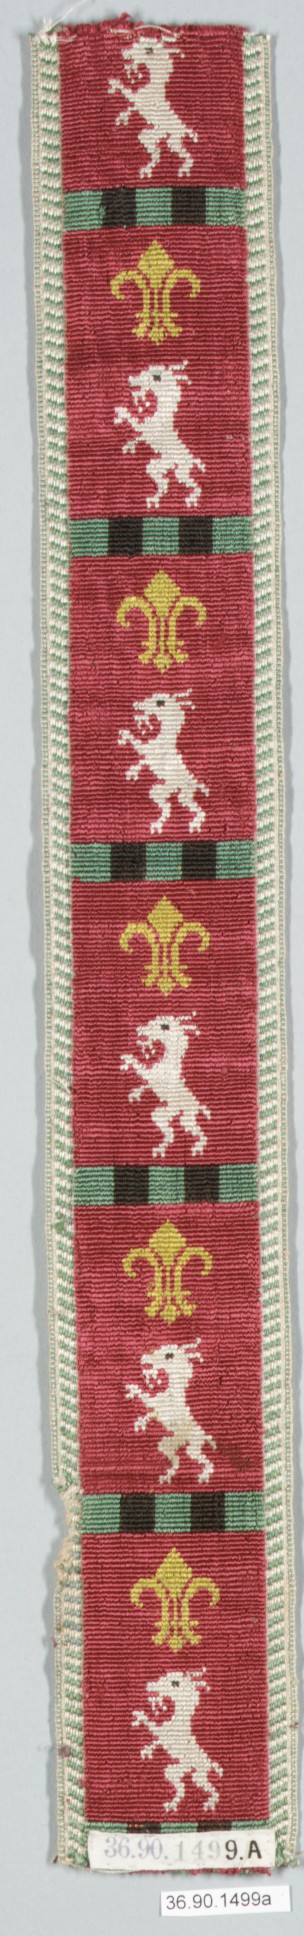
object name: galloon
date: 1701-1900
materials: silk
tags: goats